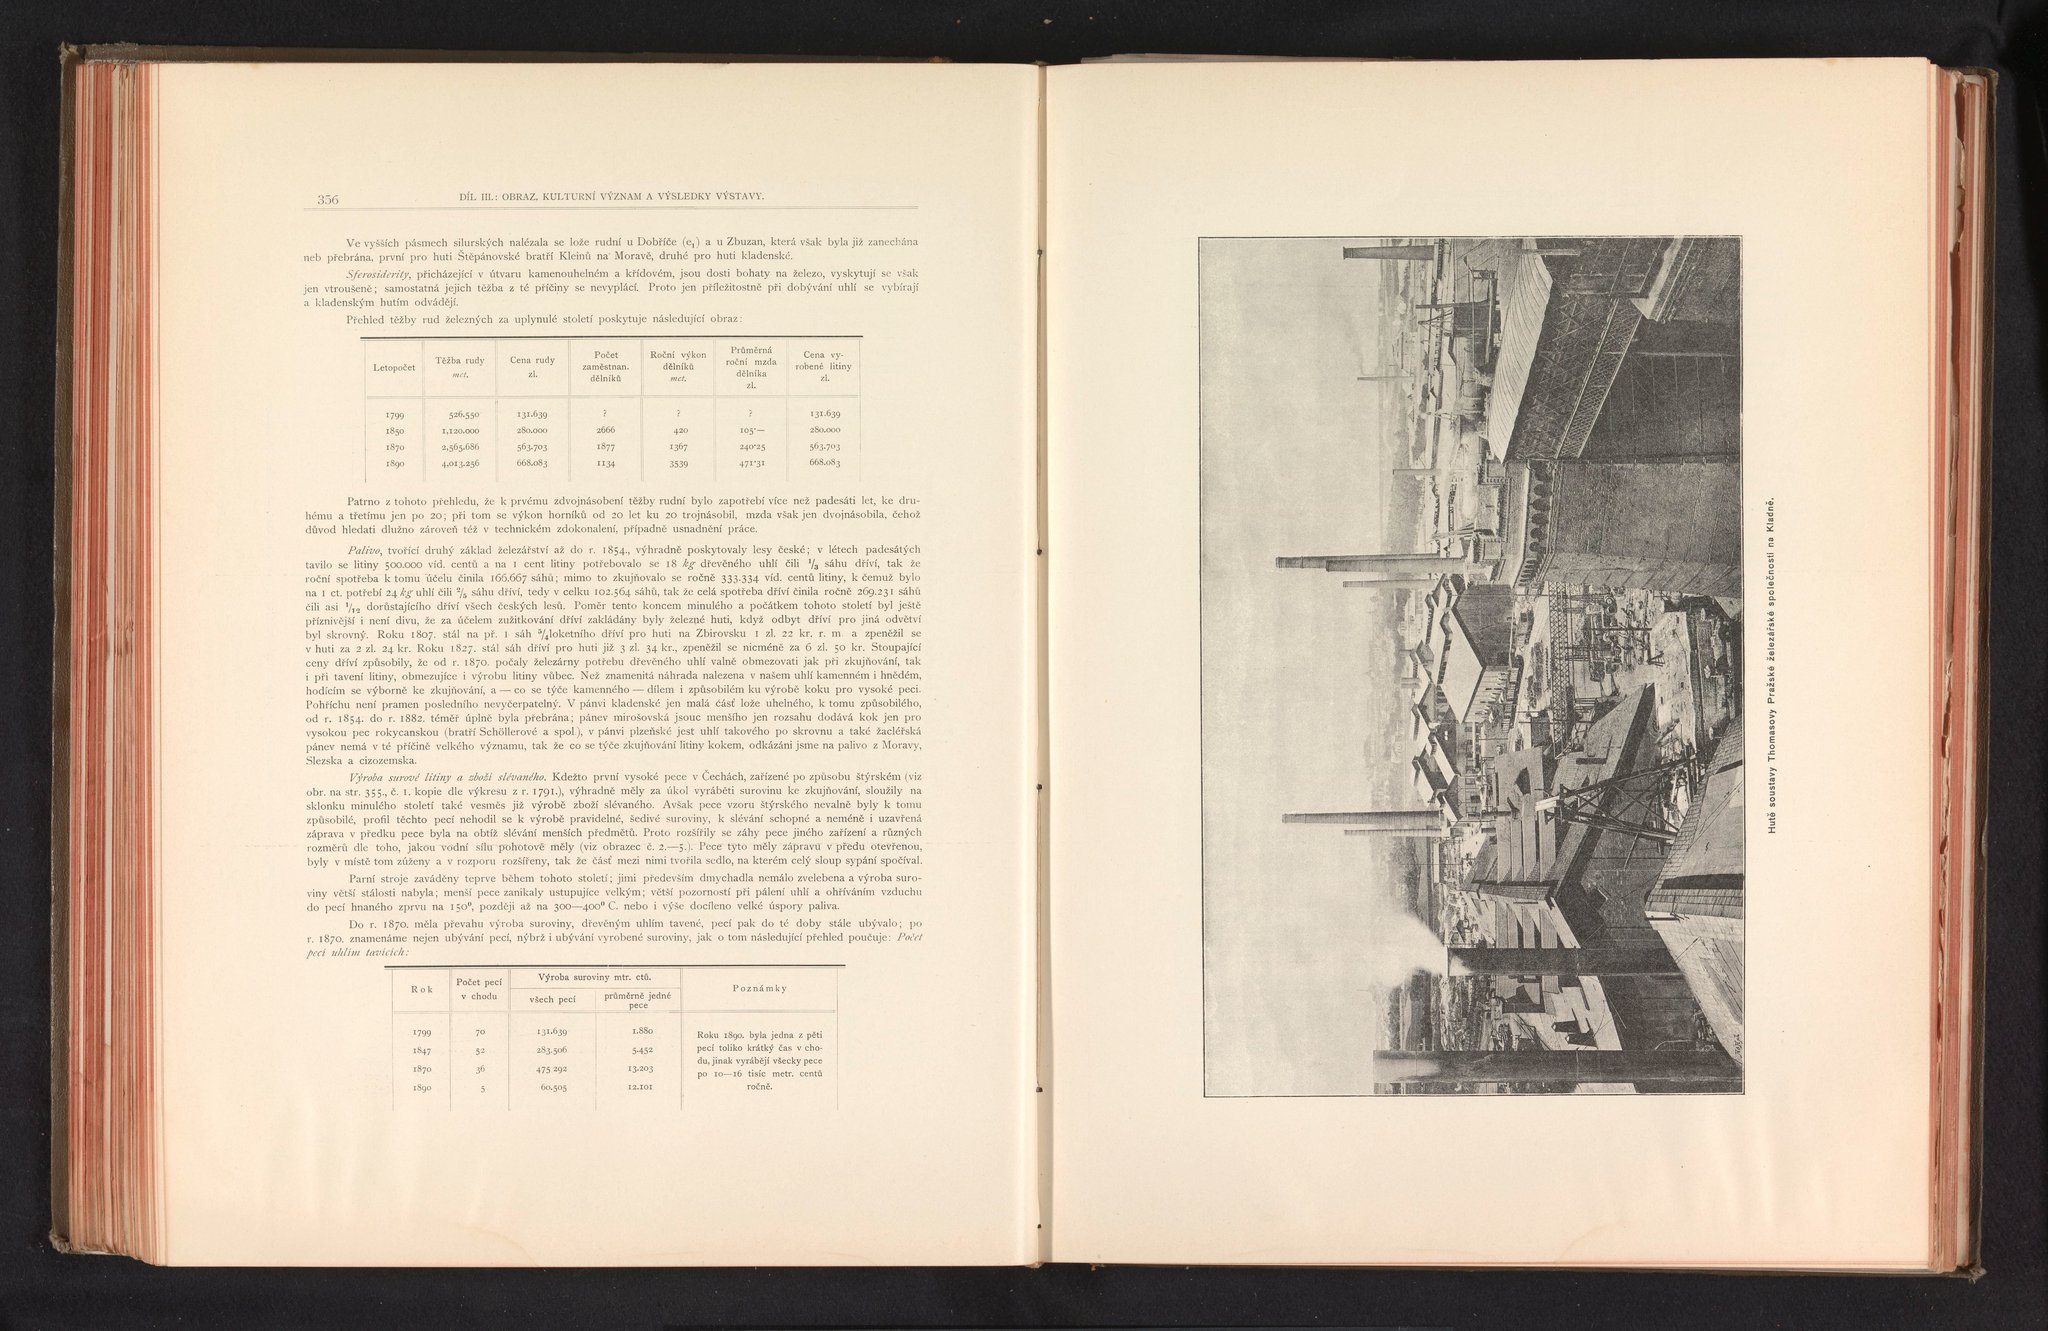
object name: page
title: Hute soustavy Thomasovy Prazské zelezárské spolecnosti na Kladne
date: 1890-1895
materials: paper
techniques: autotype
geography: kladno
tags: exterior of industrial structures, factories